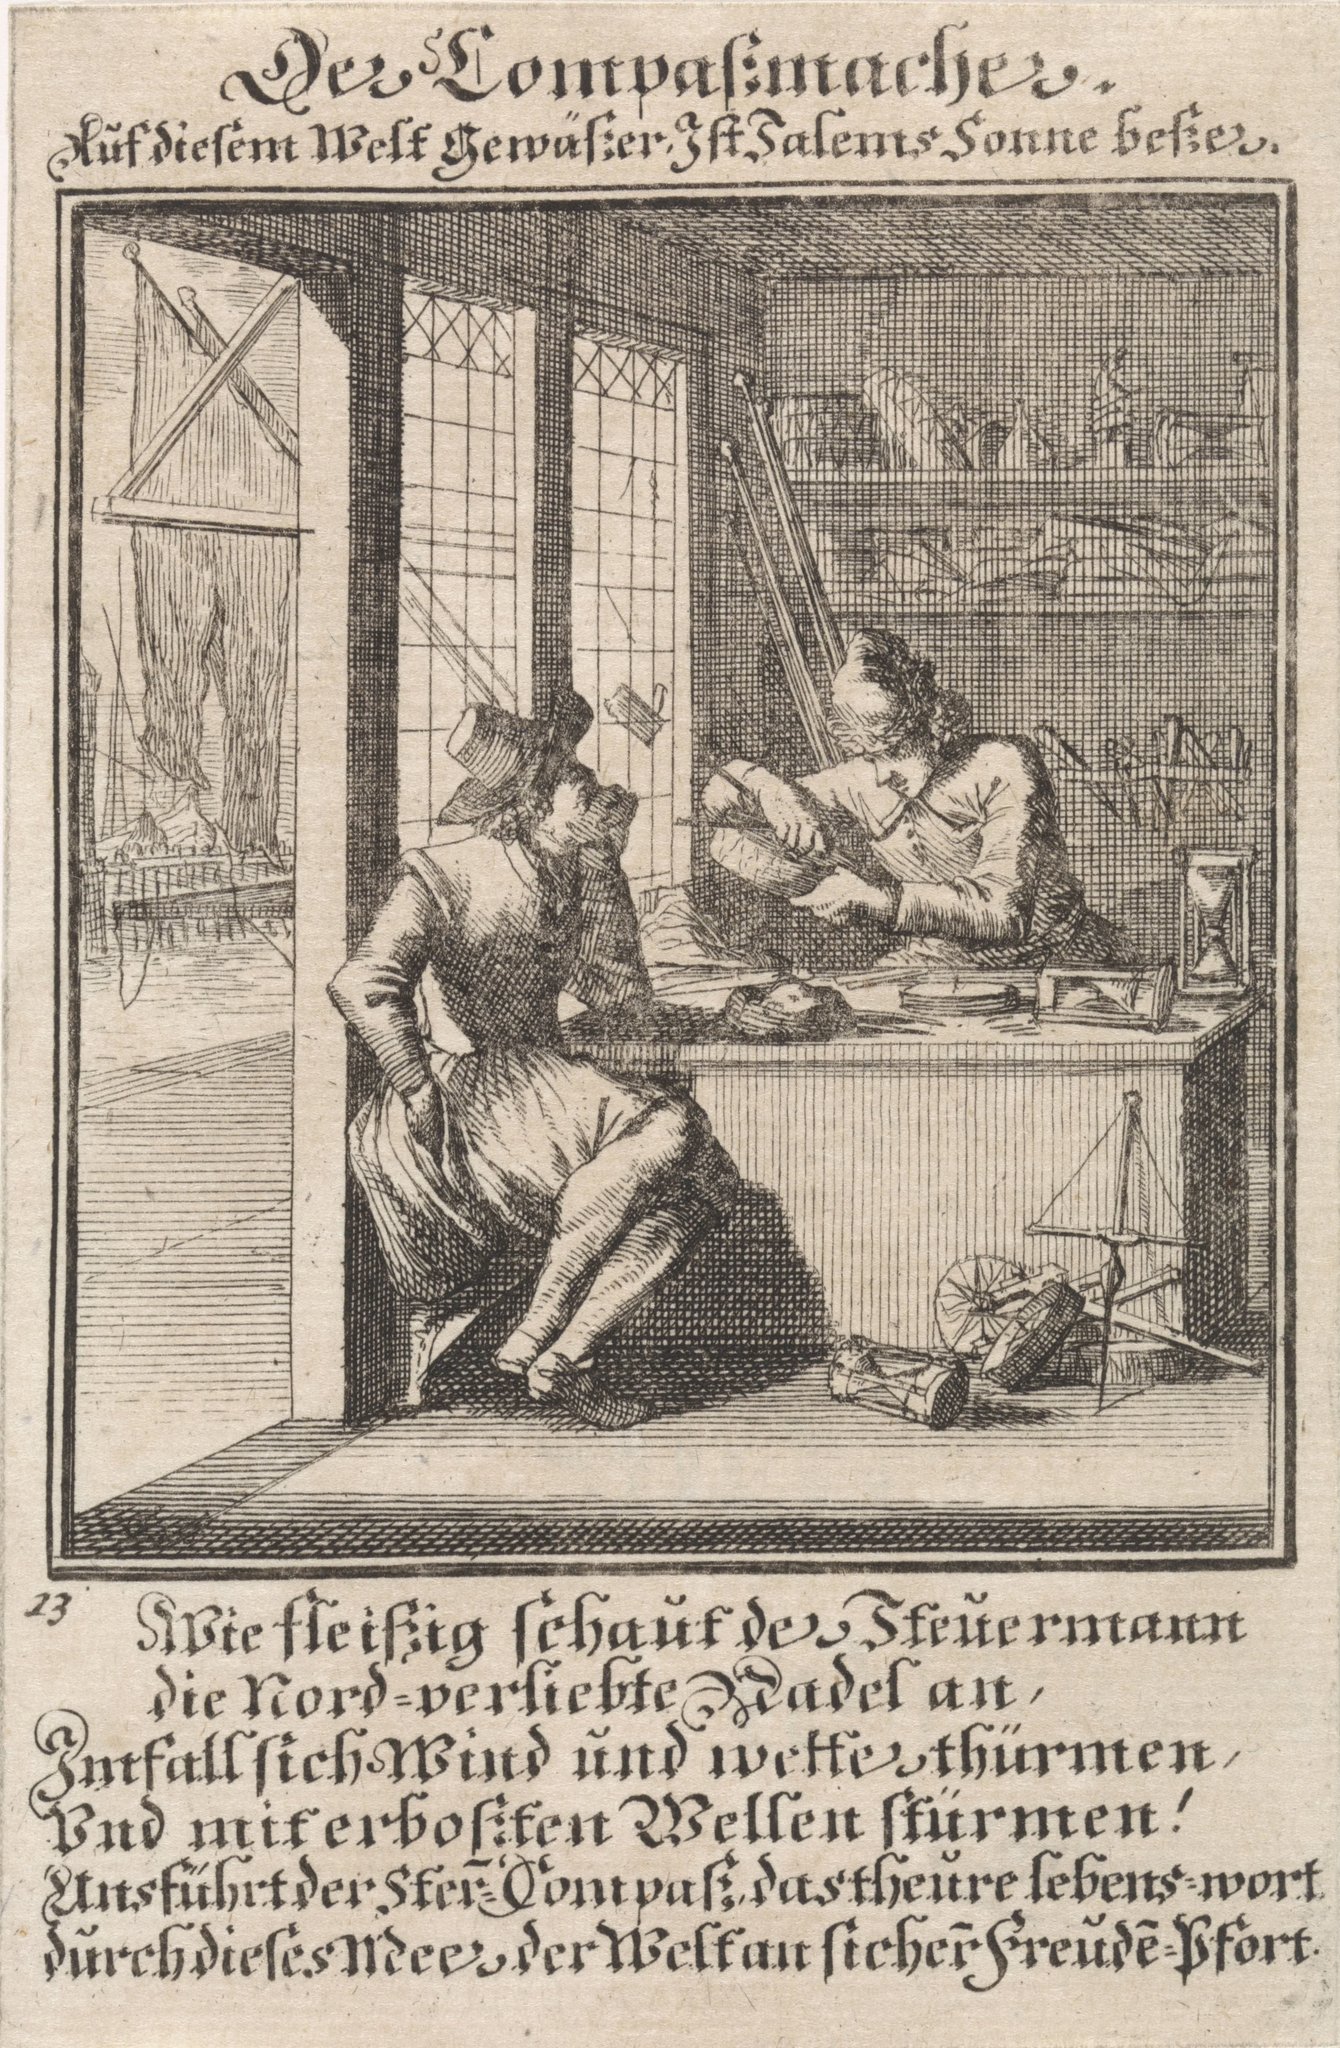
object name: book illustration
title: Kompasmaker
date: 1711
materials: paper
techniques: etching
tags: handicrafts, craftsman at work, compass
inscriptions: collector's mark: Lugt 2228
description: Illustratie uit: Sancta Clara, Abraham à. Etwas für Alle, das ist: Eine kurtze Beschreibung allerley Stands- Ambts- und Gewerbs-Persohnen (...), 3 delen (1699-1733). Würtzburg: Martin Frantz Hertz, 1711, dl. III, p. 115. Het betreft hier de tweede druk van deel III.